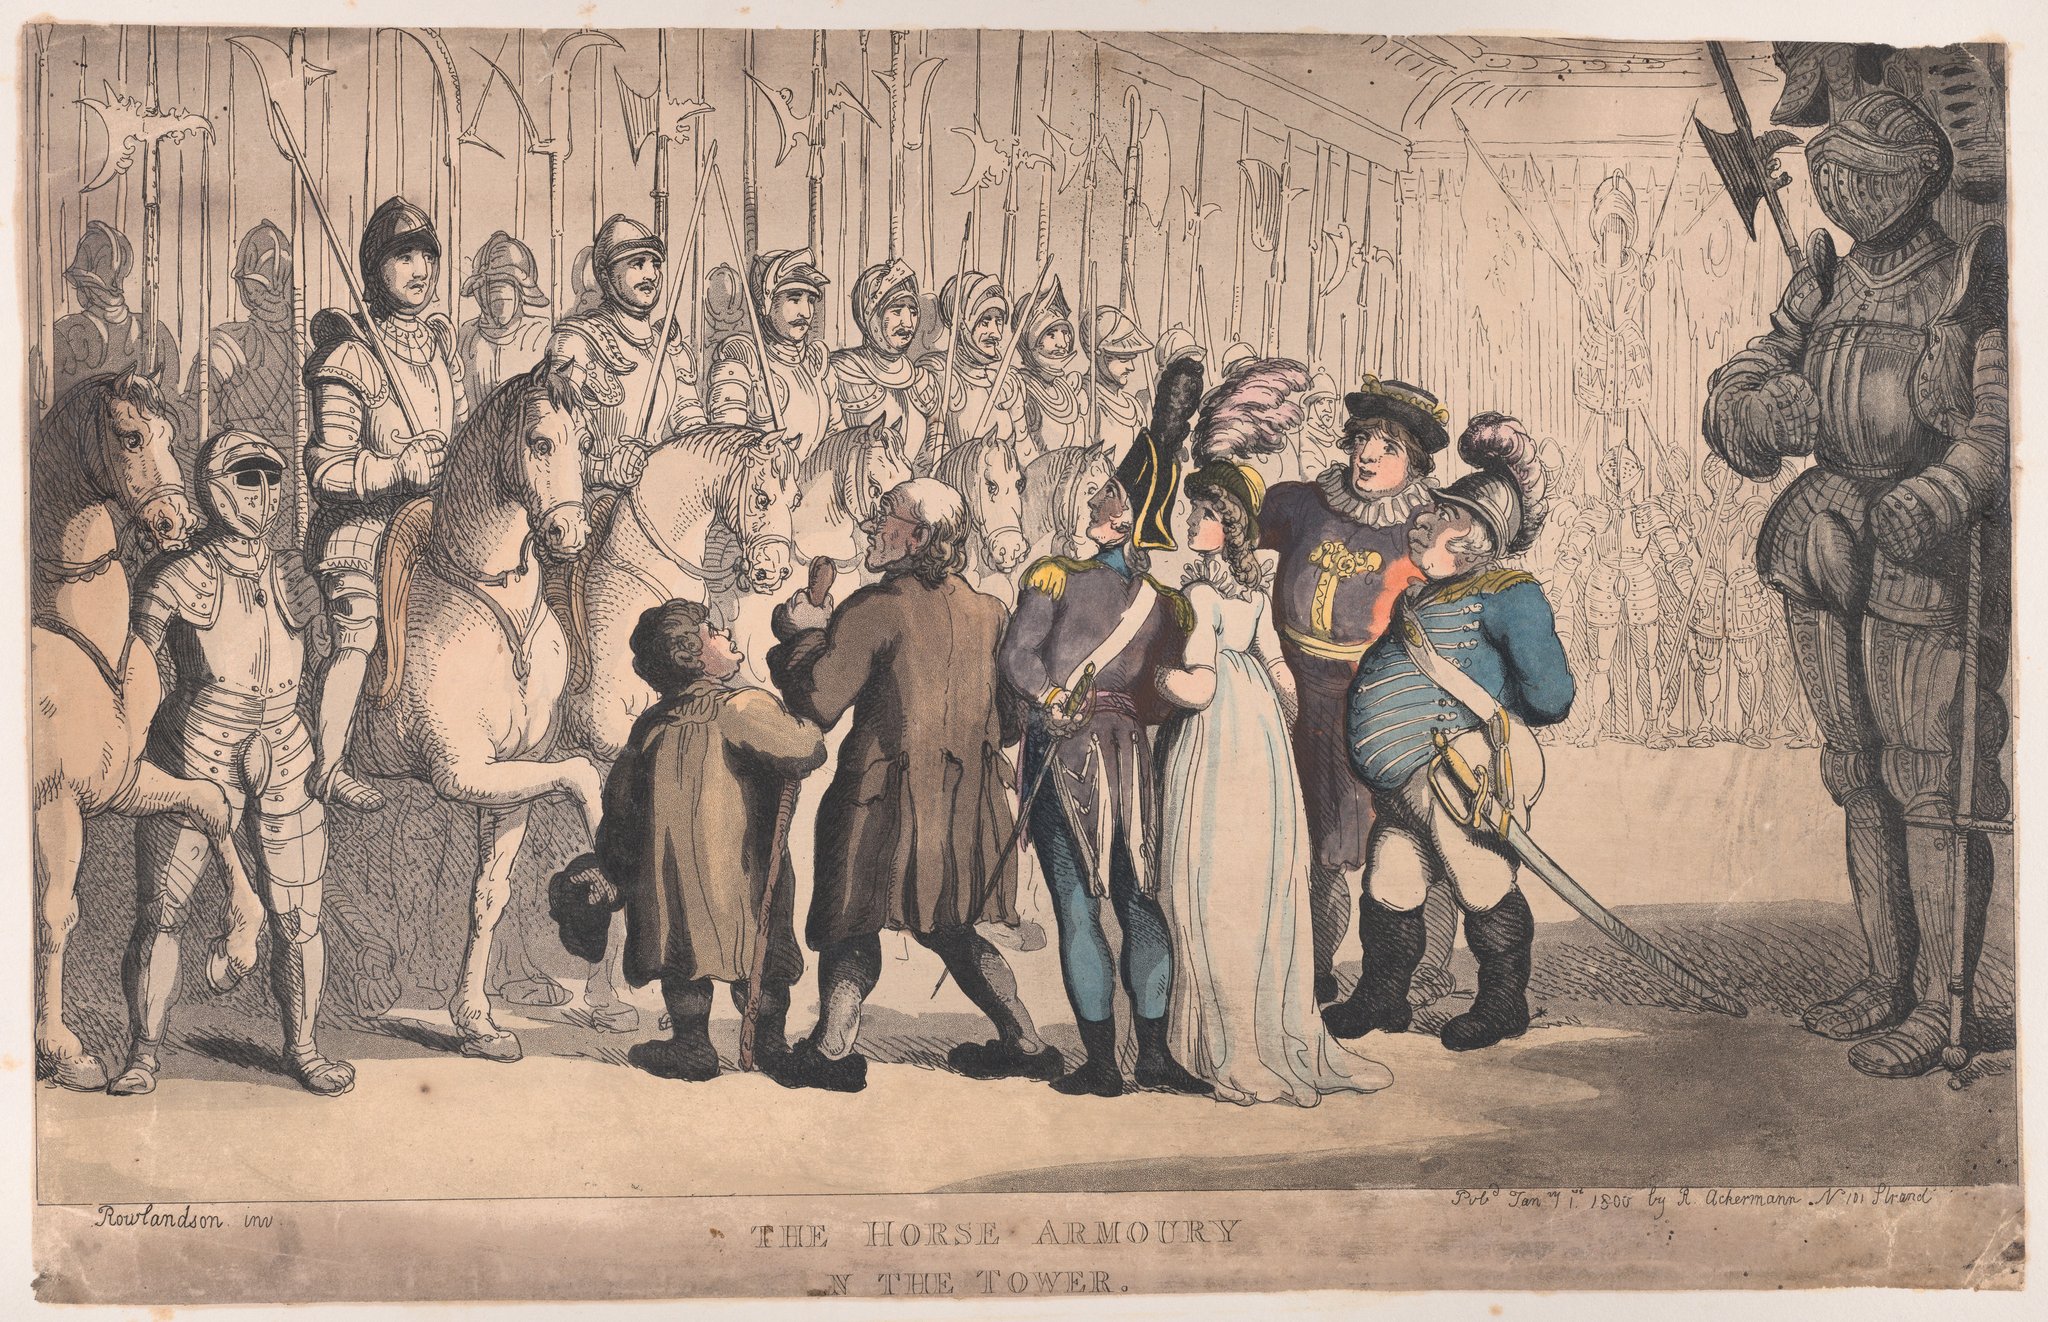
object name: print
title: The Horse Armoury in the Tower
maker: thomas rowlandson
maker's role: artist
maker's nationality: british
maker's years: 1757-1827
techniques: etching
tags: soldiers,armor,men,women,horses